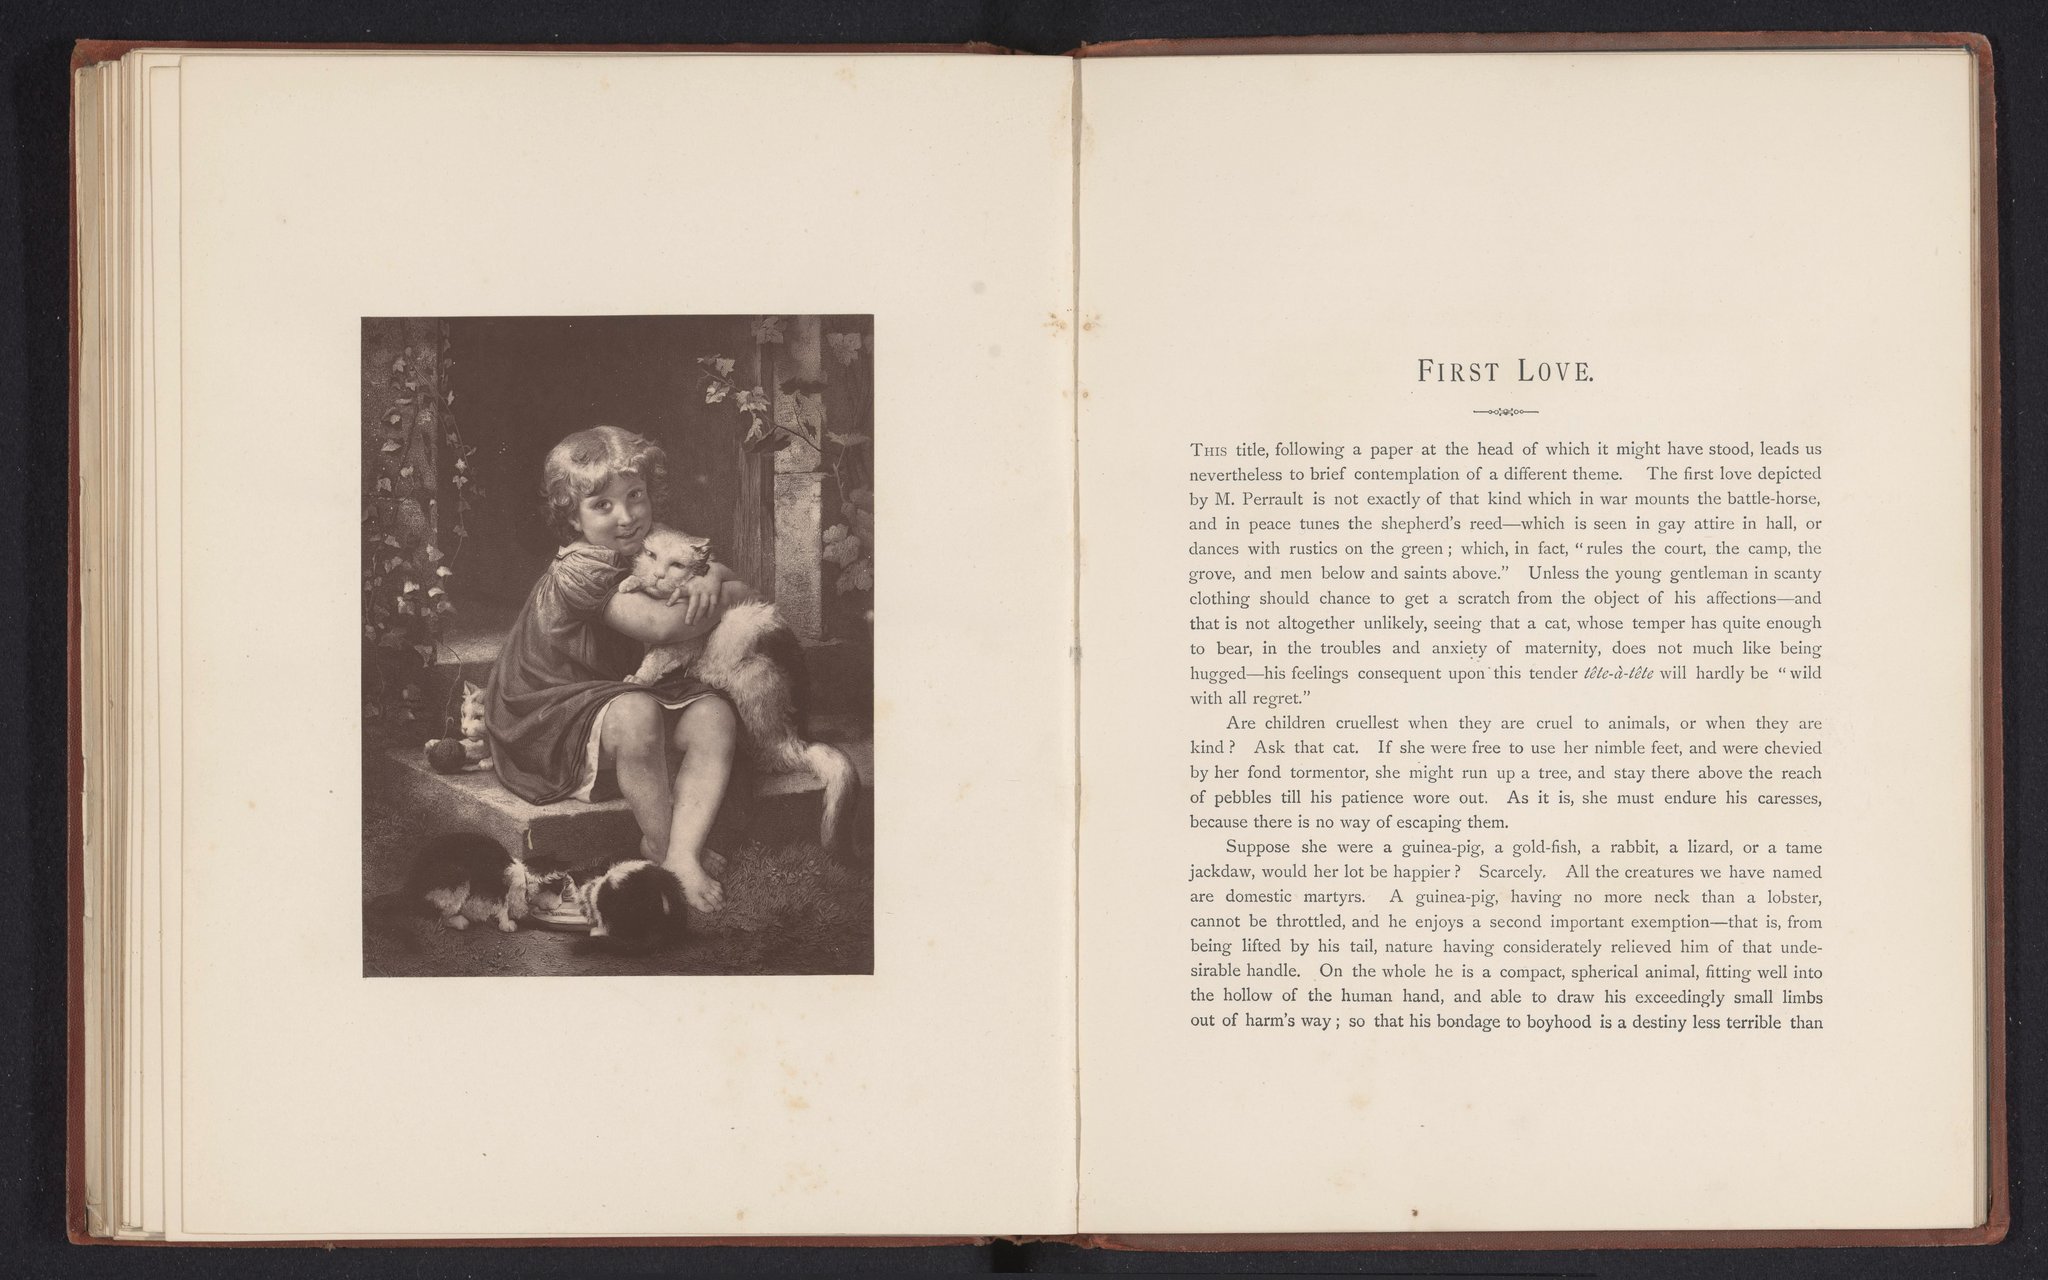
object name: photomechanical print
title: Fotoreproductie van een prent naar een schilderij, voorstellende een meisje met katten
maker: Anonymous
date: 1861-1871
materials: paper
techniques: woodburytype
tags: cat, girl (child between toddler and youth)